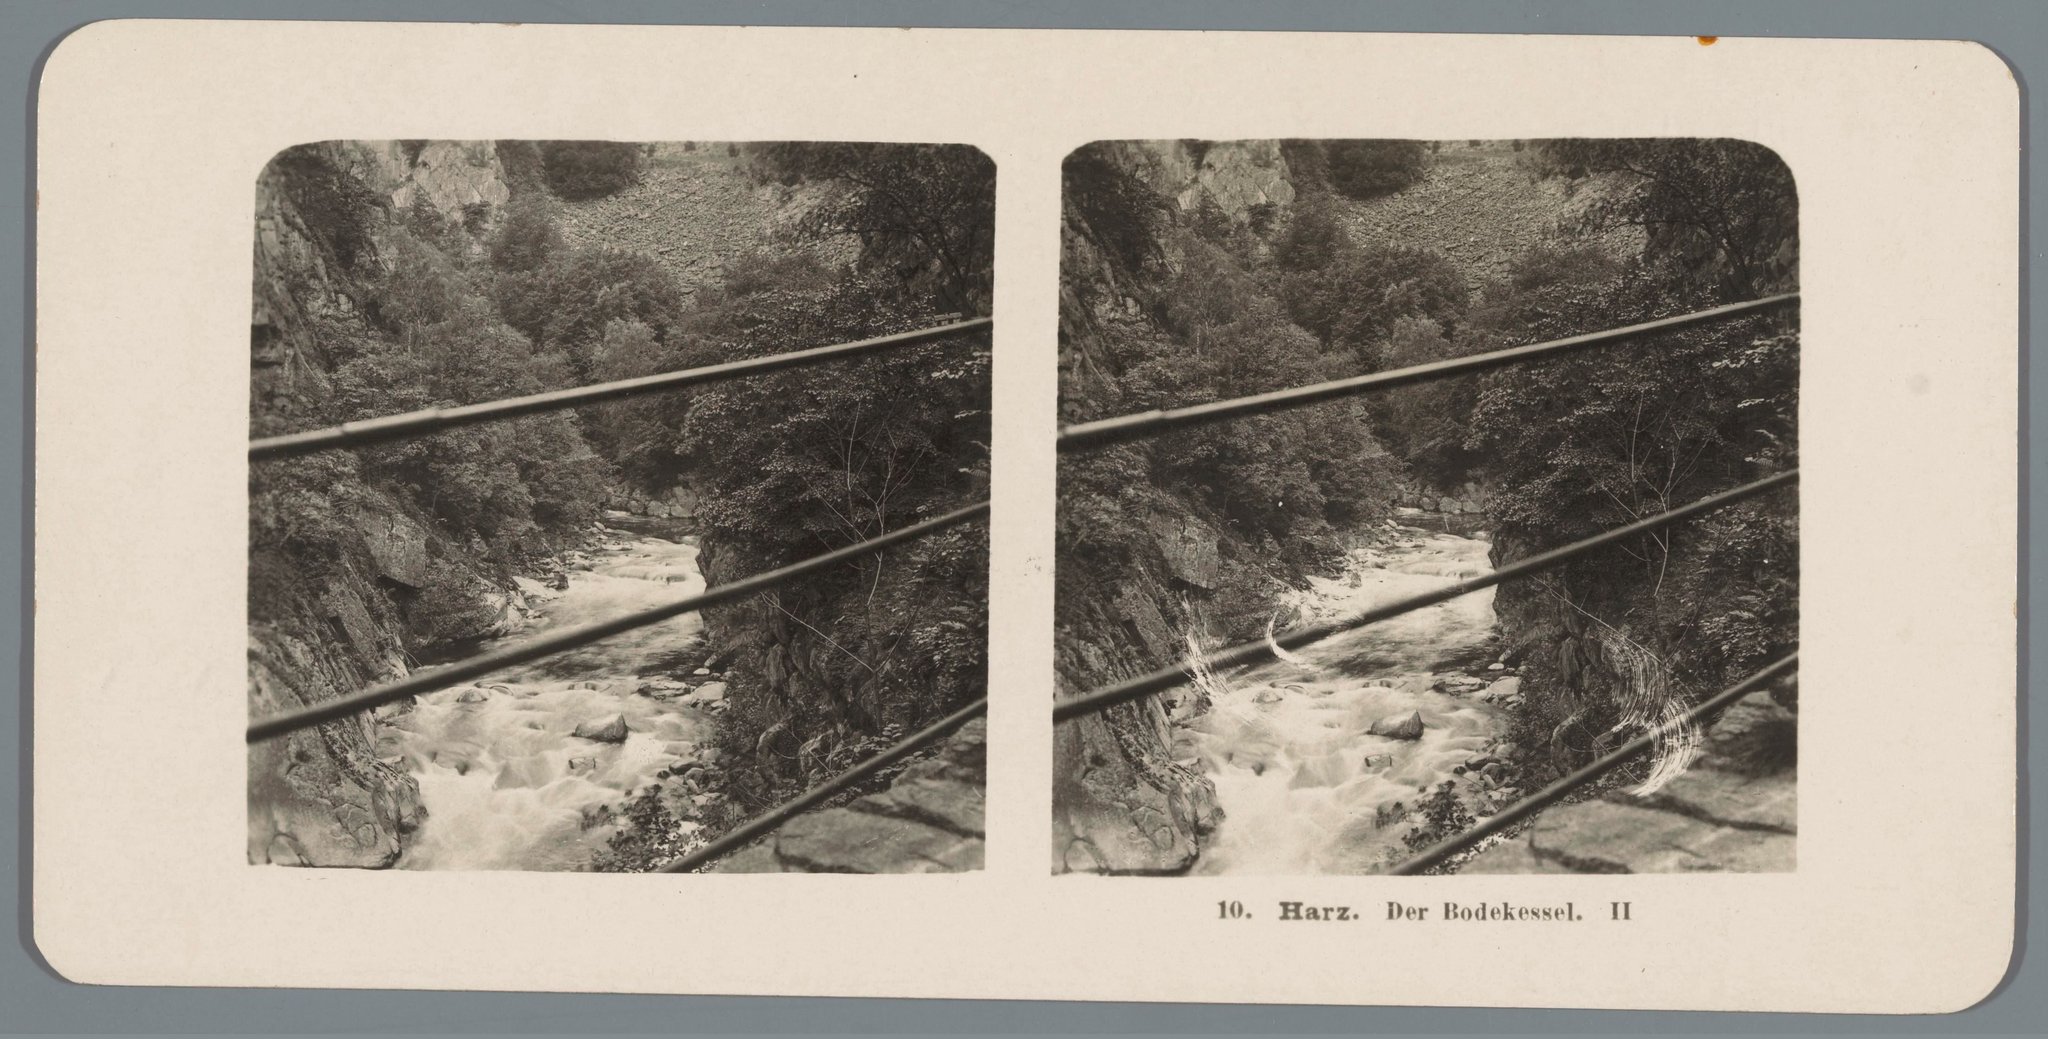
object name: stereograph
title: Stroomversnellingen in de Bode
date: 1904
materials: cardboard, photographic support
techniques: gelatin silver print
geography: bodetal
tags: dale, valley, rapids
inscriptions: inscription: ‘Neue Photographische Gesellschaft A.-G., Steglitz-Berlin 1904.’, number: ‘10.’